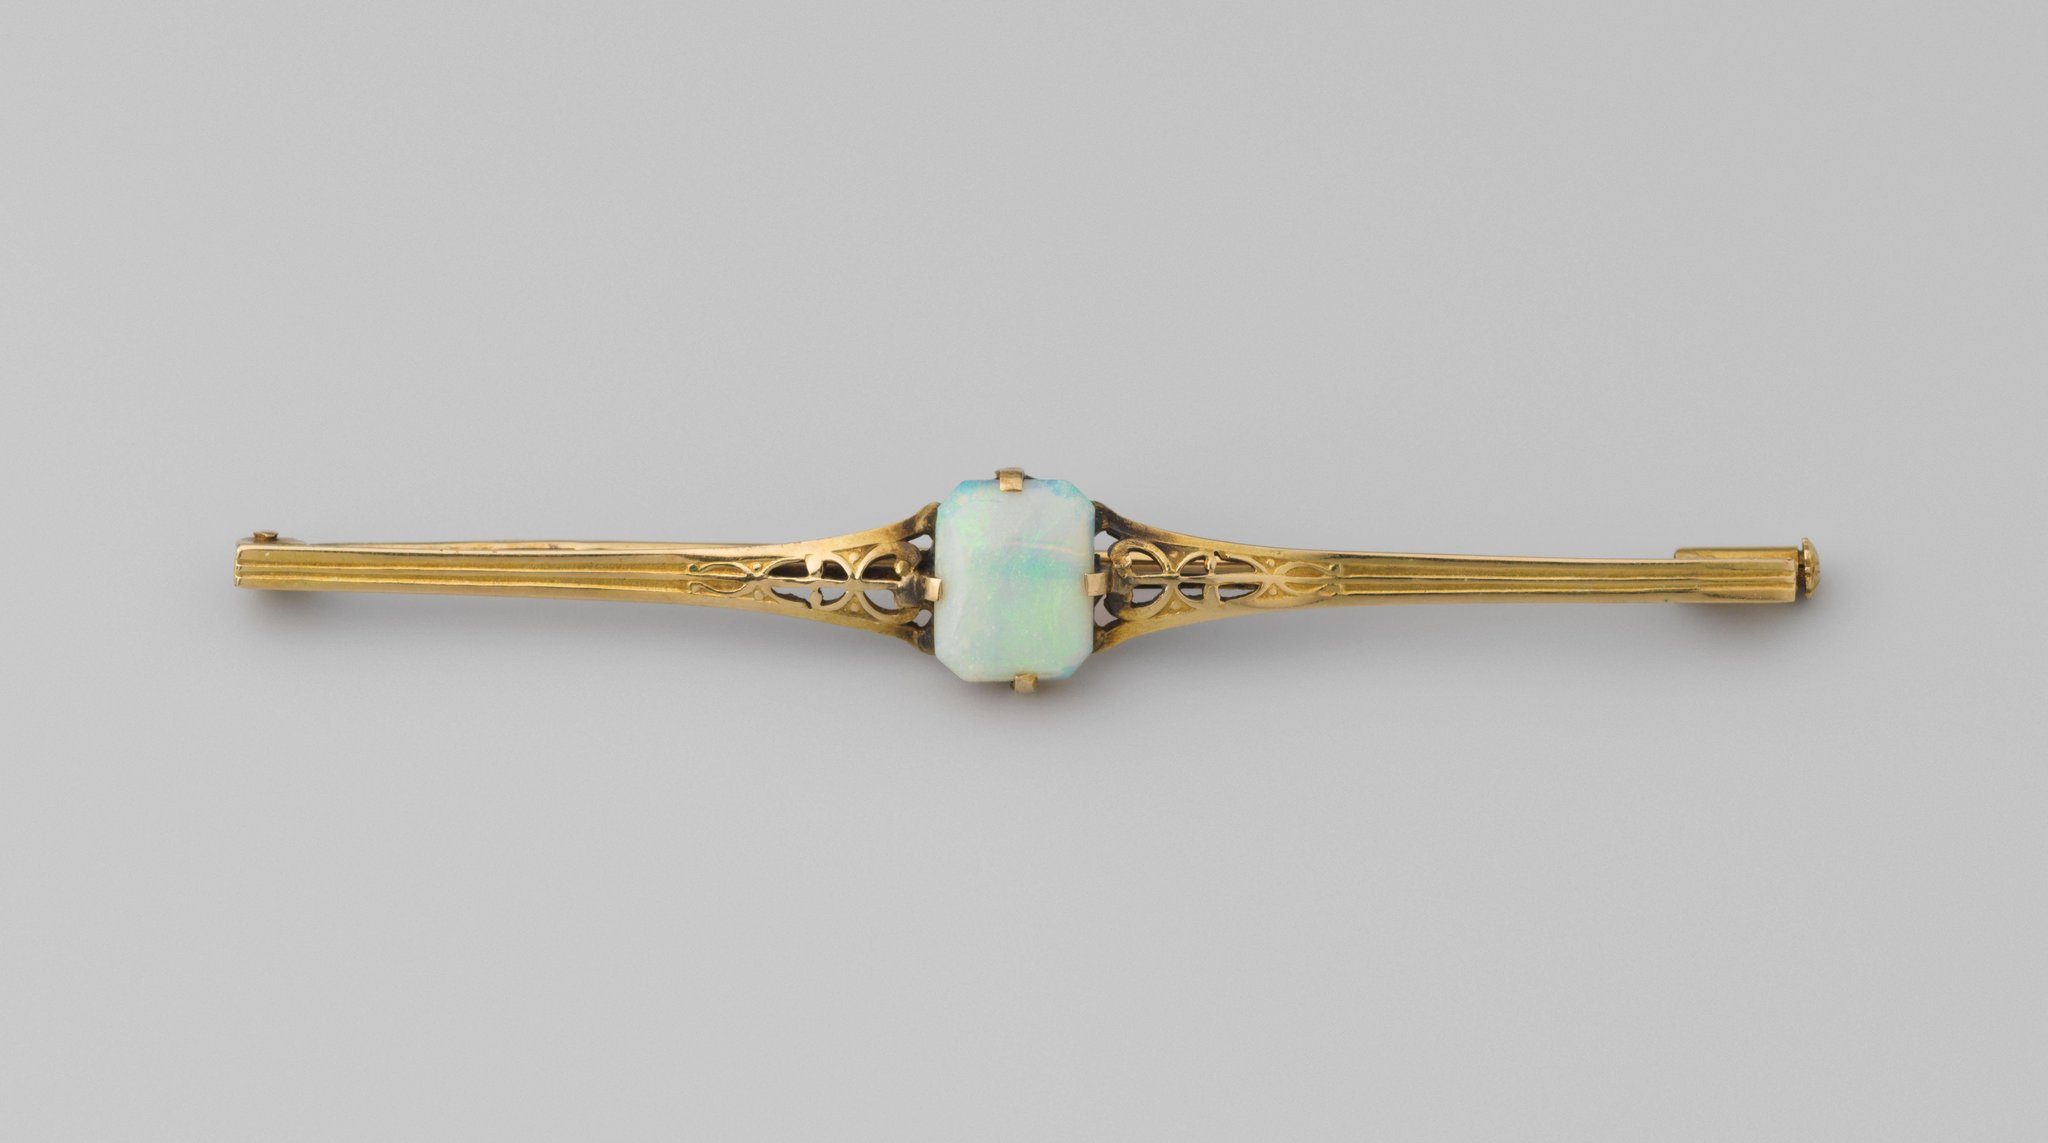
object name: brooch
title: Brochette van goud met opaal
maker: Anonymous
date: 1921-1953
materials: gold, opal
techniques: grinding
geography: netherlands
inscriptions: alloy mark, maker's mark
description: Brochette van goud met langwerpig cabochon geslepen opaal voorzien van een kanonsluiting.